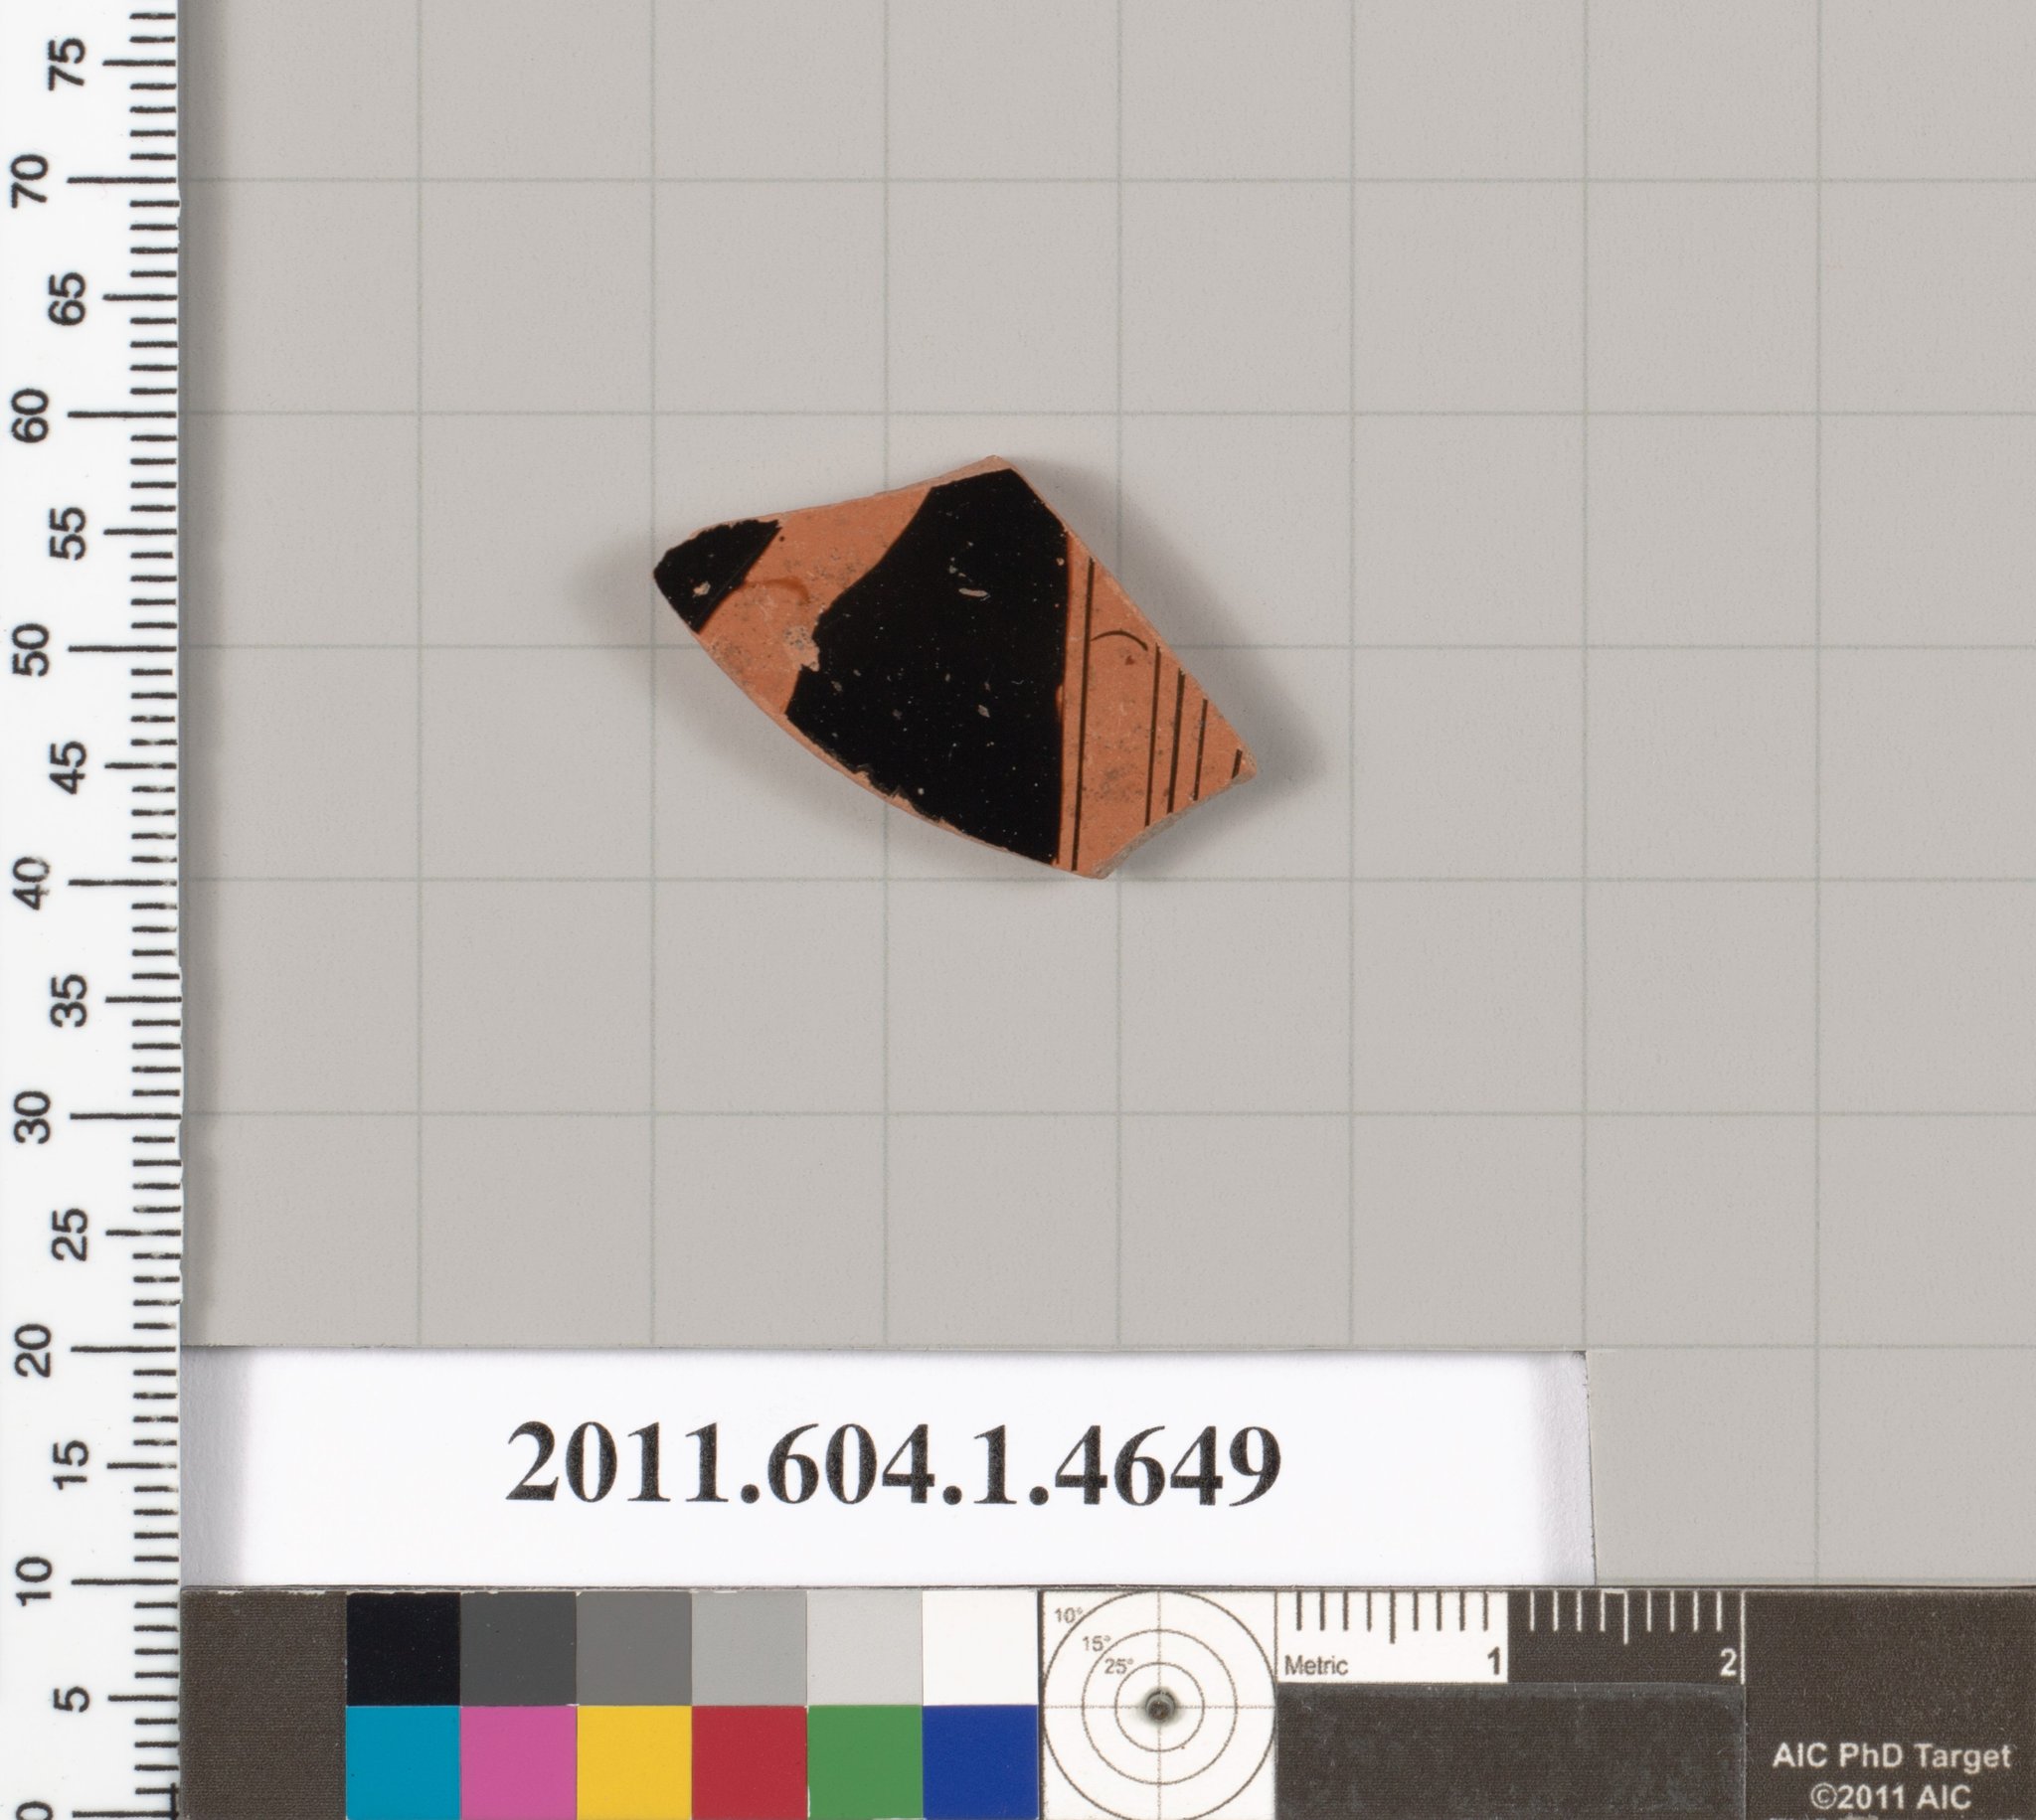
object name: kylix fragment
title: Terracotta fragment of a kylix (drinking cup)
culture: greek, attic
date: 475-451 BCE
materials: terracotta